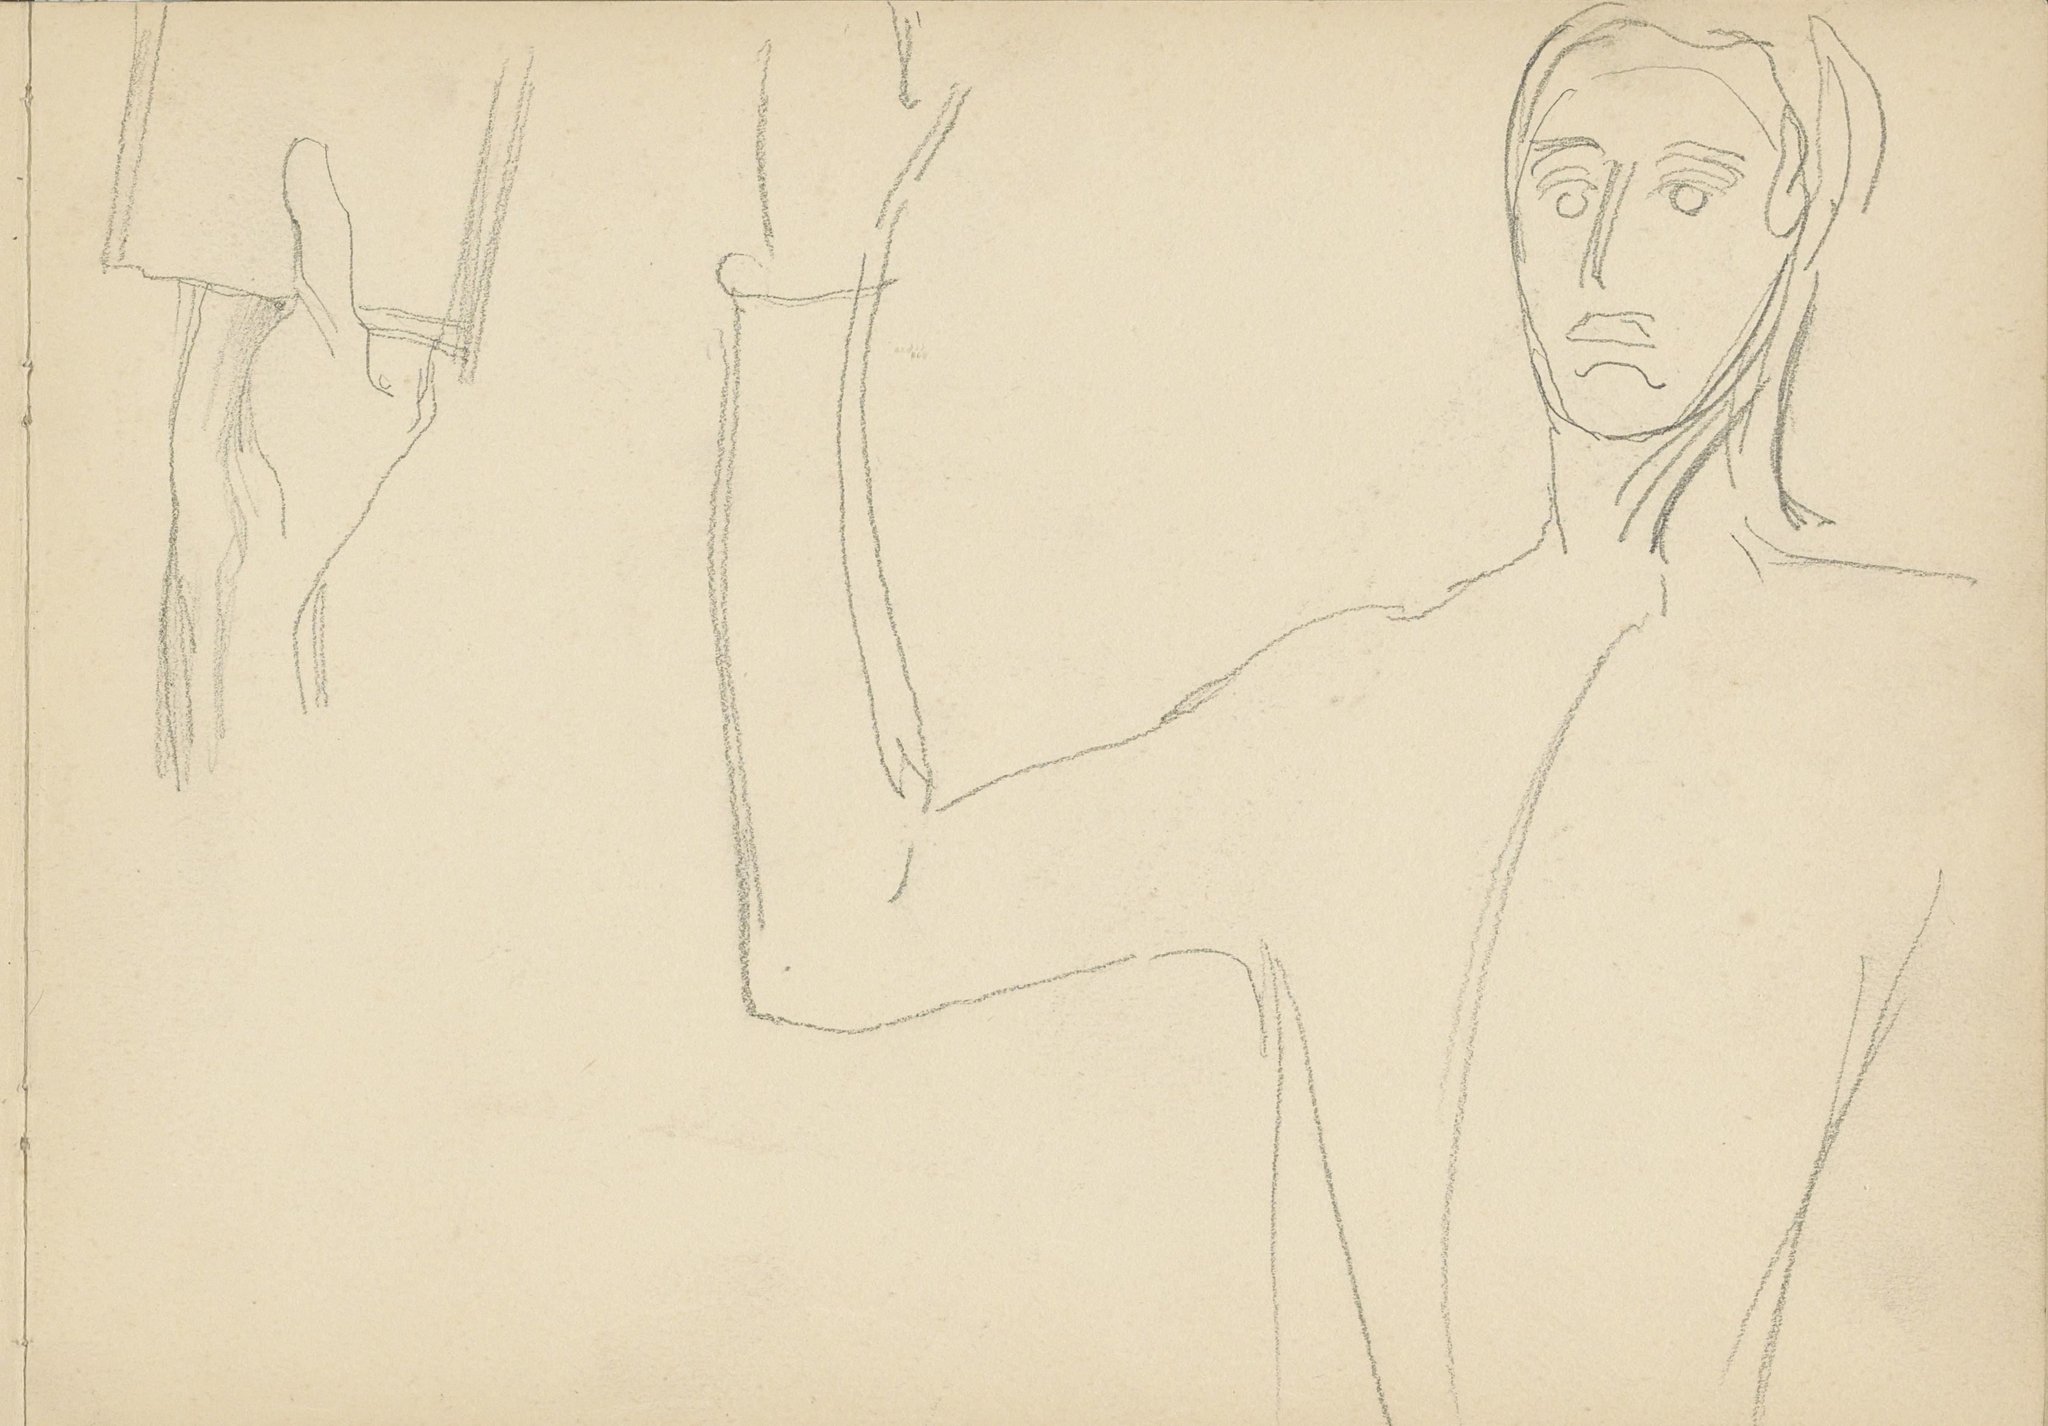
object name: sketchbook leaf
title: Man met een opgeheven arm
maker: antoon derkinderen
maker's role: draughtsman, painter, print maker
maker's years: 1859-1925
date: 1869-1925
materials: paper, pencil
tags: arm raised upward, hand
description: Tevens een studie van een hand die een stuk papier vasthoudt. Blad 3 recto uit een schetsboek met 28 bladen.